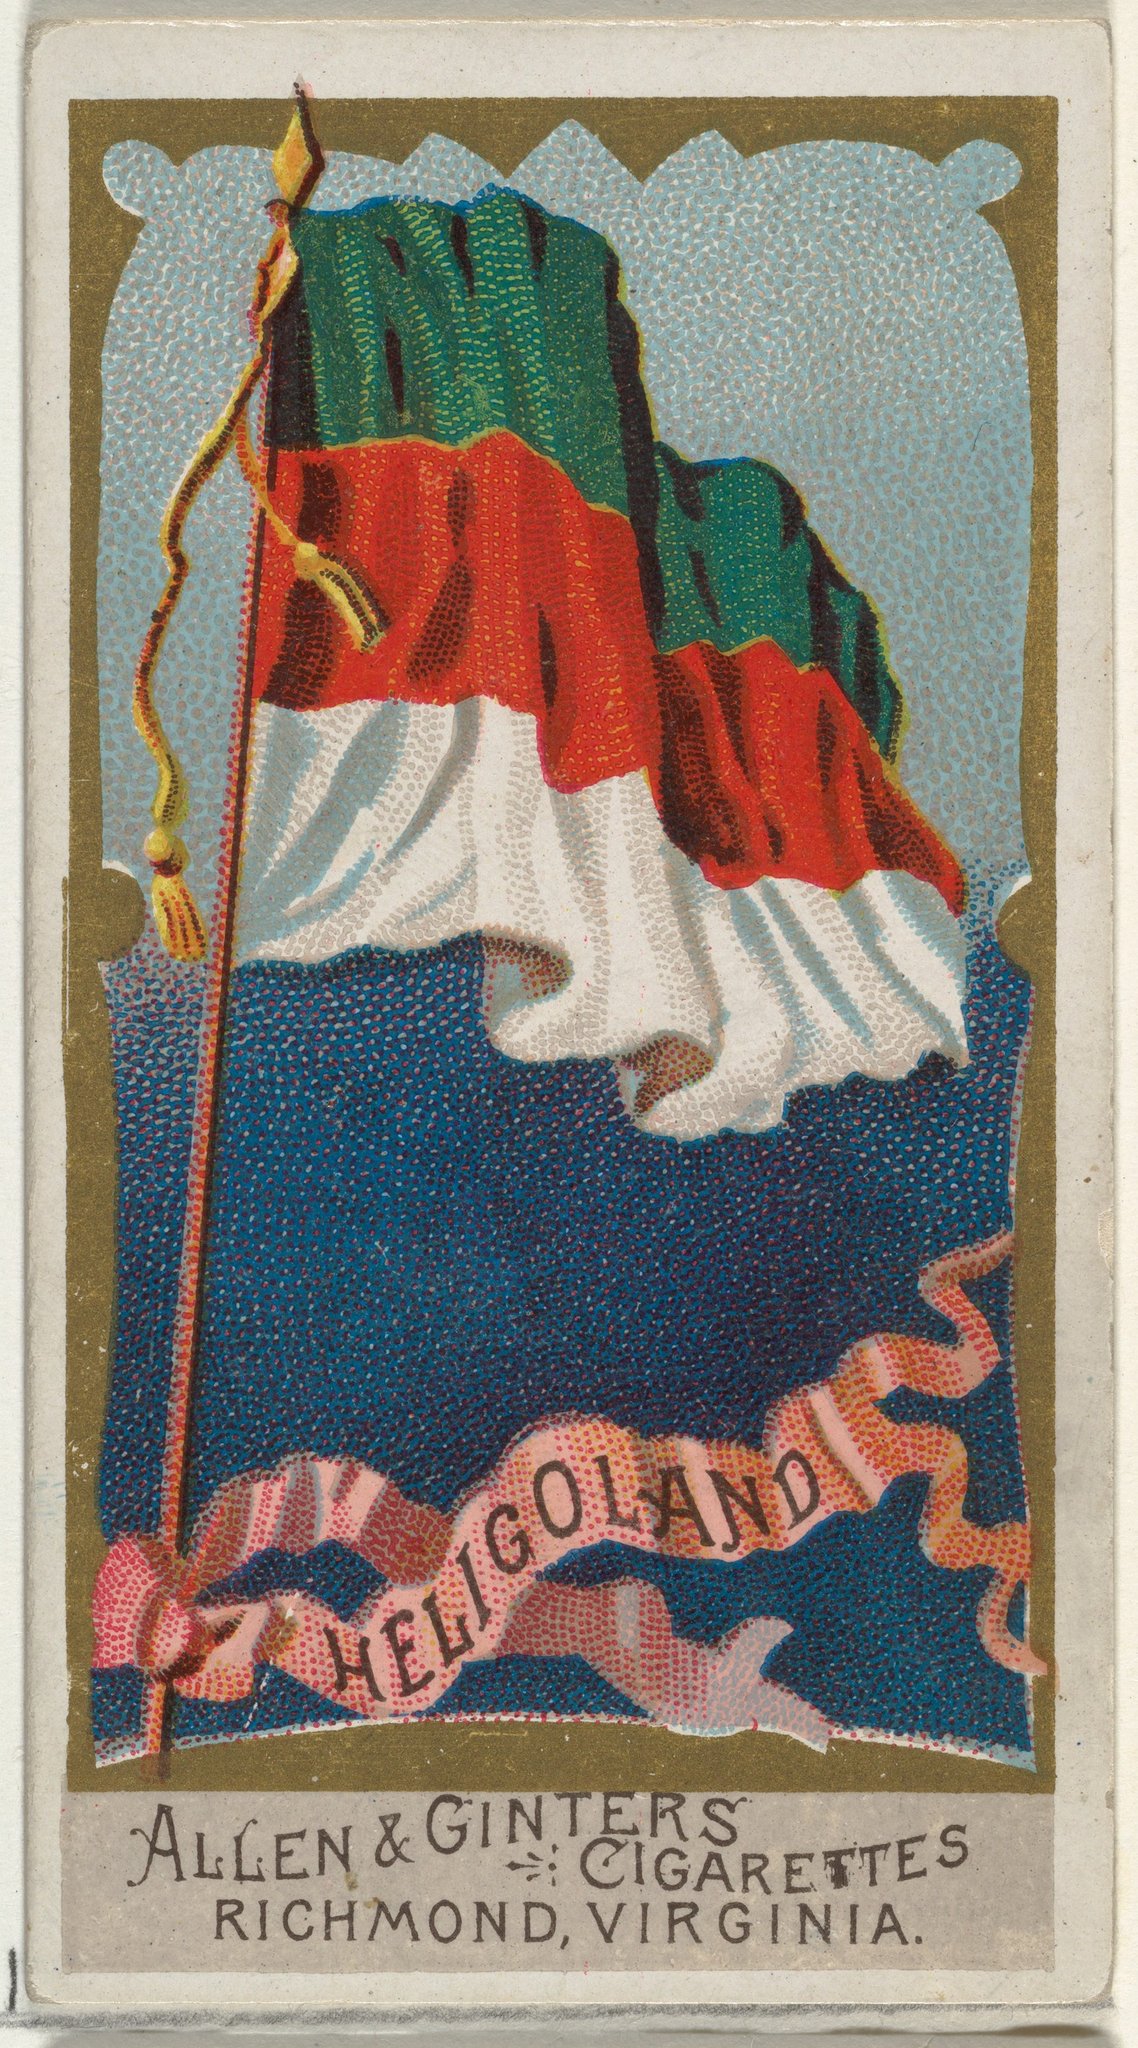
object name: print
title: Heligoland, from Flags of All Nations, Series 2 (N10) for Allen & Ginter Cigarettes Brands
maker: allen & ginter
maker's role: publisher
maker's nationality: american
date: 1890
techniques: color lithograph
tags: flags